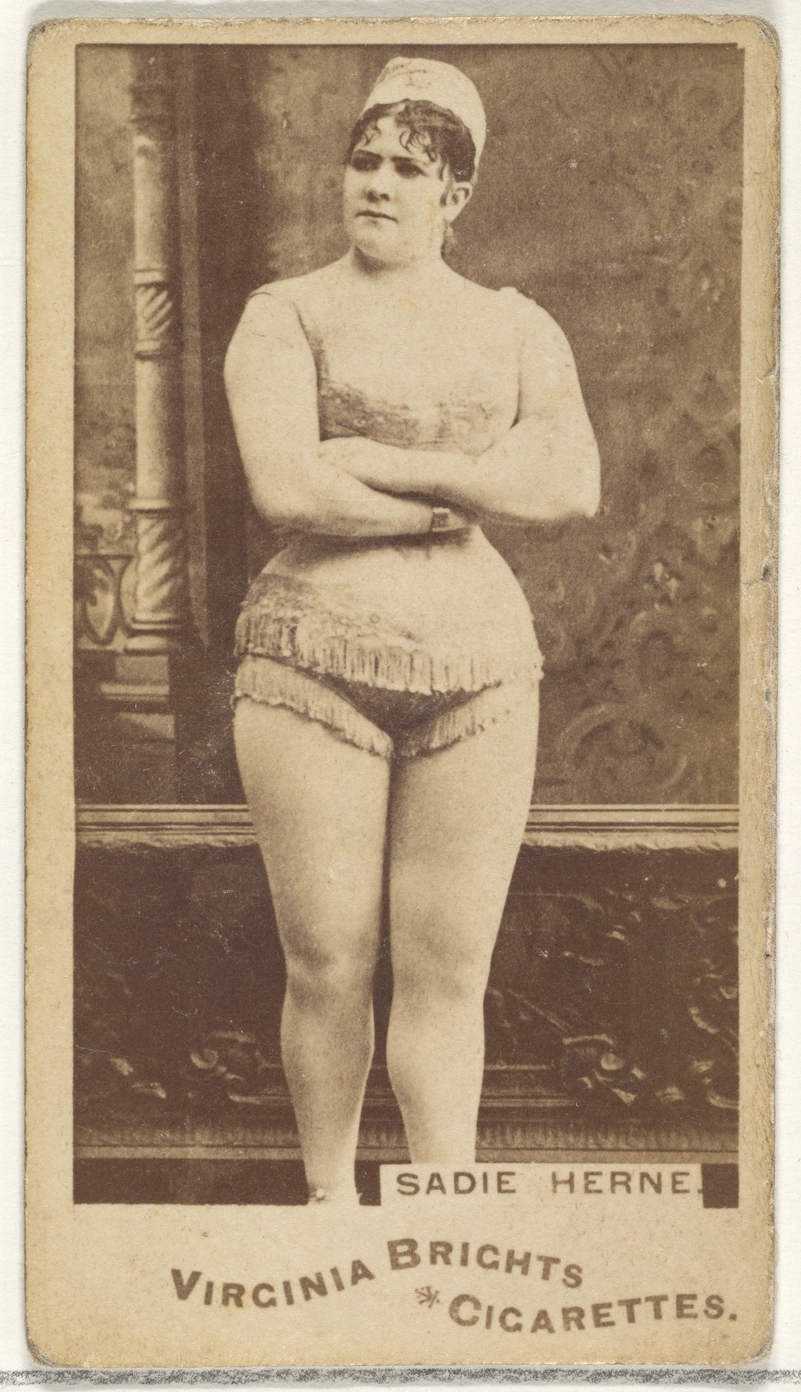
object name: photograph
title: Sadie Herne, from the Actors and Actresses series (N45, Type 1) for Virginia Brights Cigarettes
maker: allen & ginter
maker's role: publisher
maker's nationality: american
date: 1888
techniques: albumen silver print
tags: portraits,women,actresses